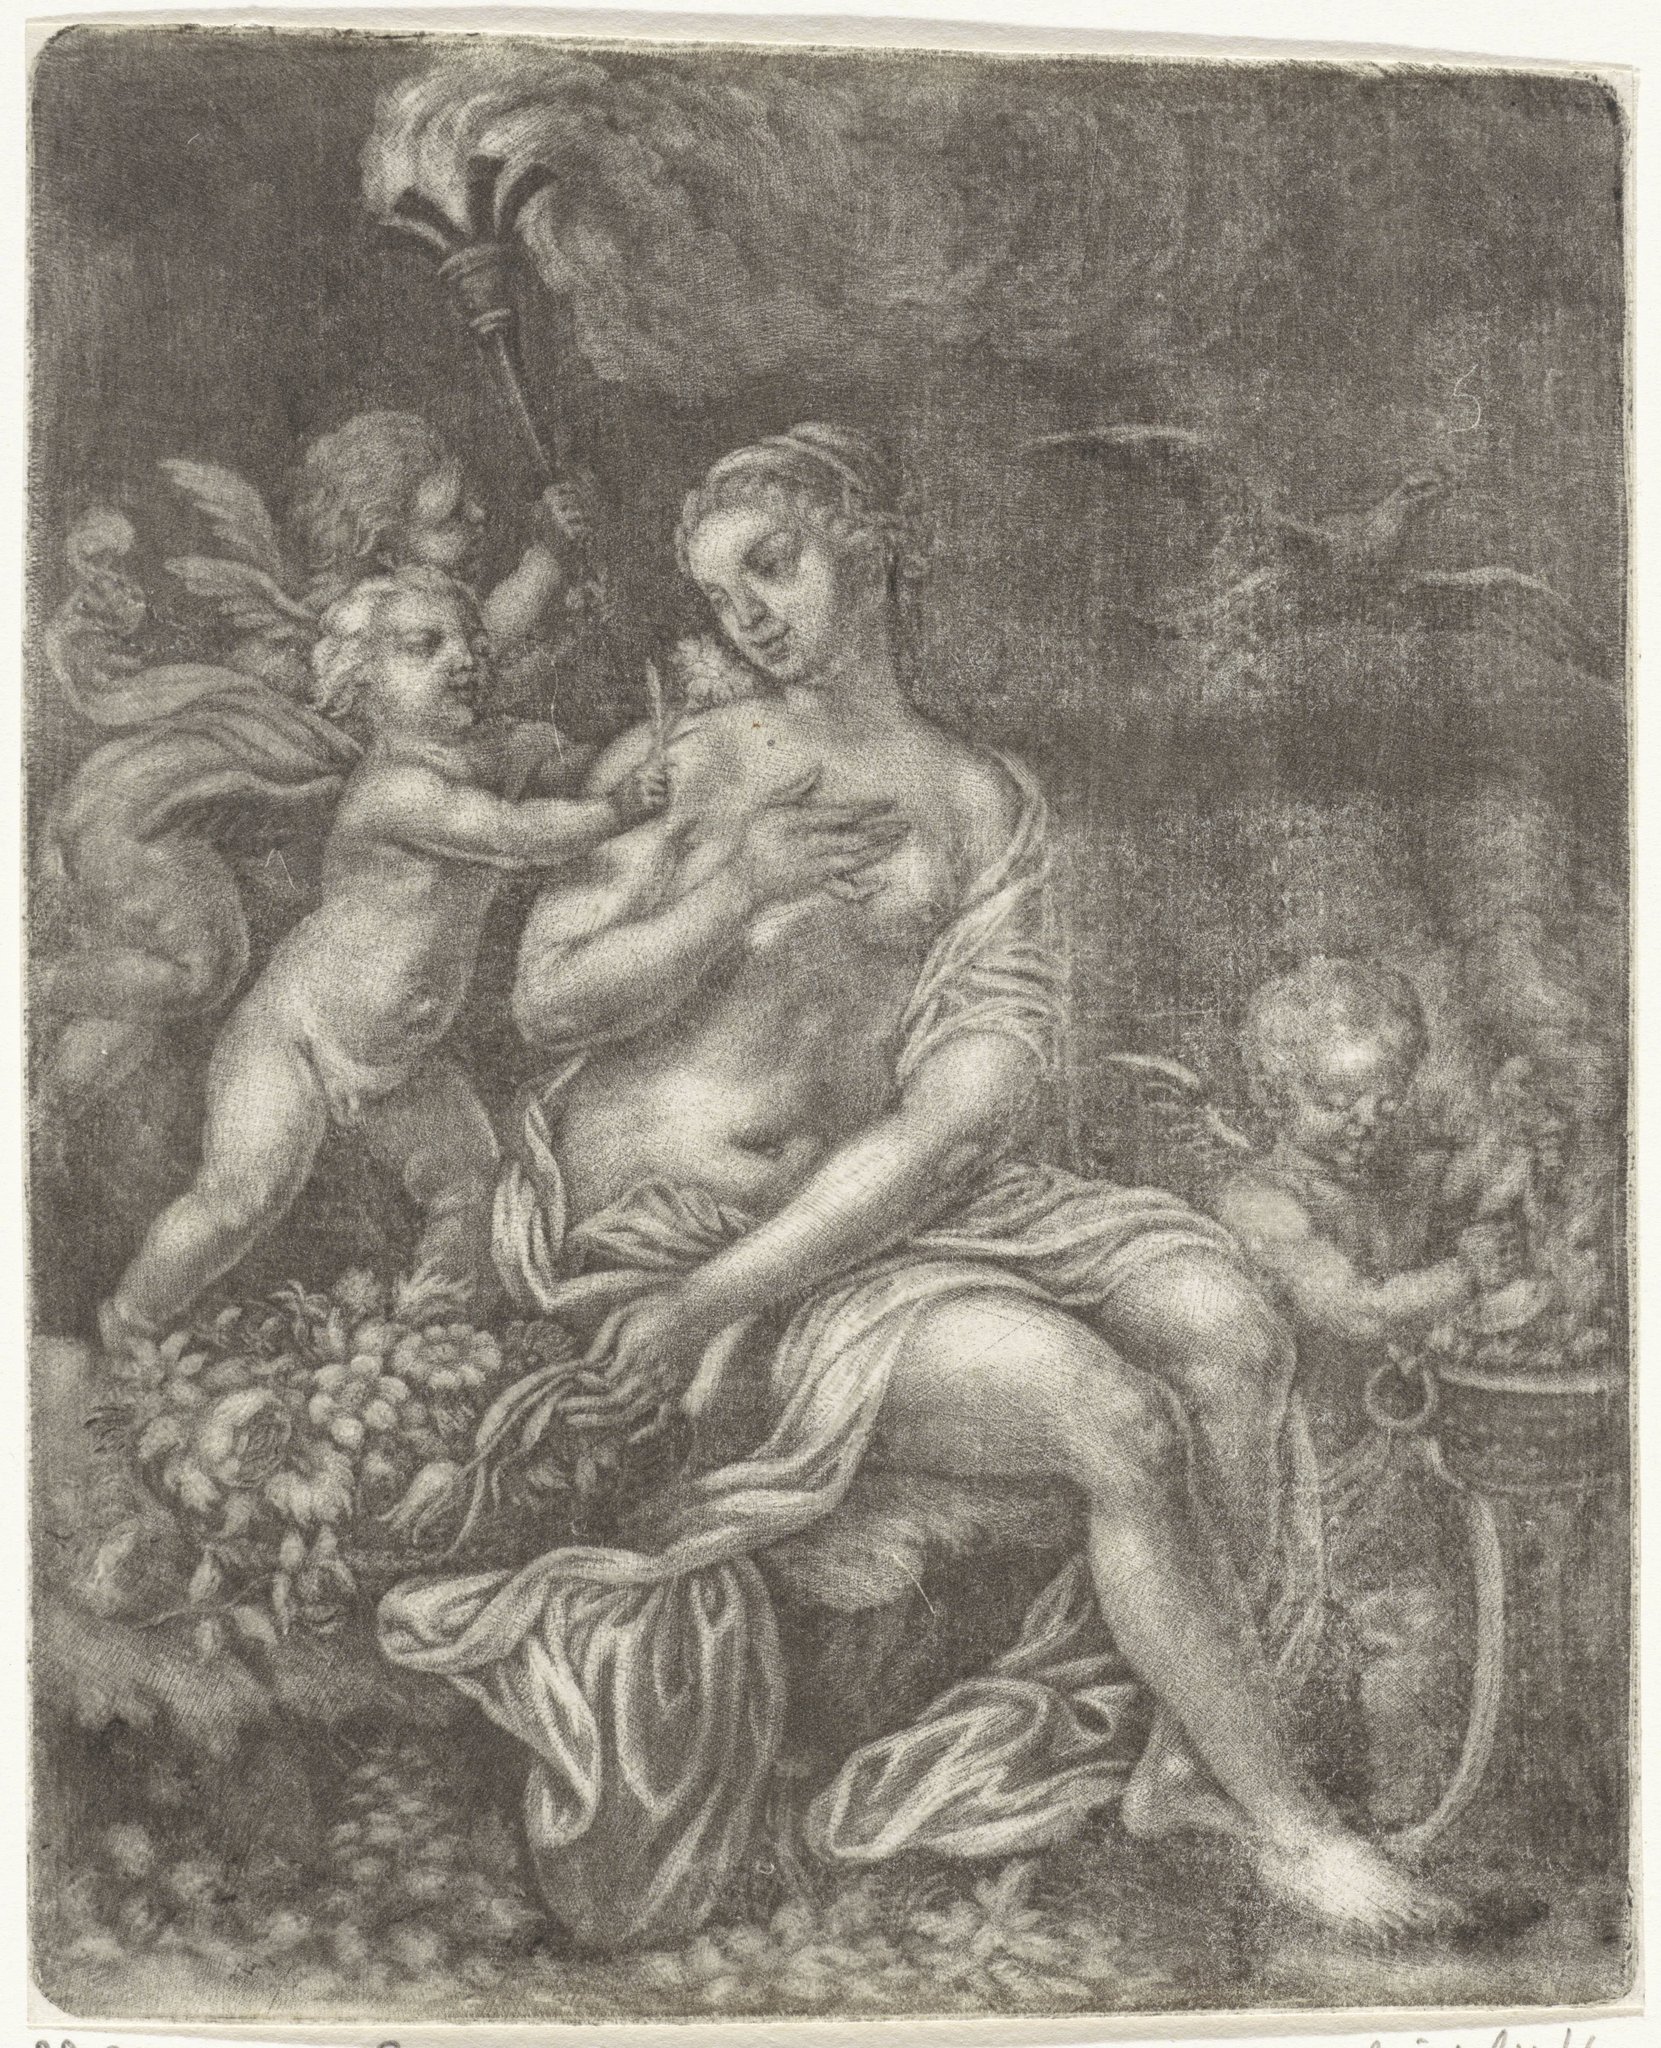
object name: print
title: Venus, een duif en drie putti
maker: jan van somer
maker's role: draughtsman, print maker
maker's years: 1645-1699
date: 1655-1700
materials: paper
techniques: mezzotint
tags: (story of) venus (aphrodite)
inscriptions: collector's mark: Lugt 2228